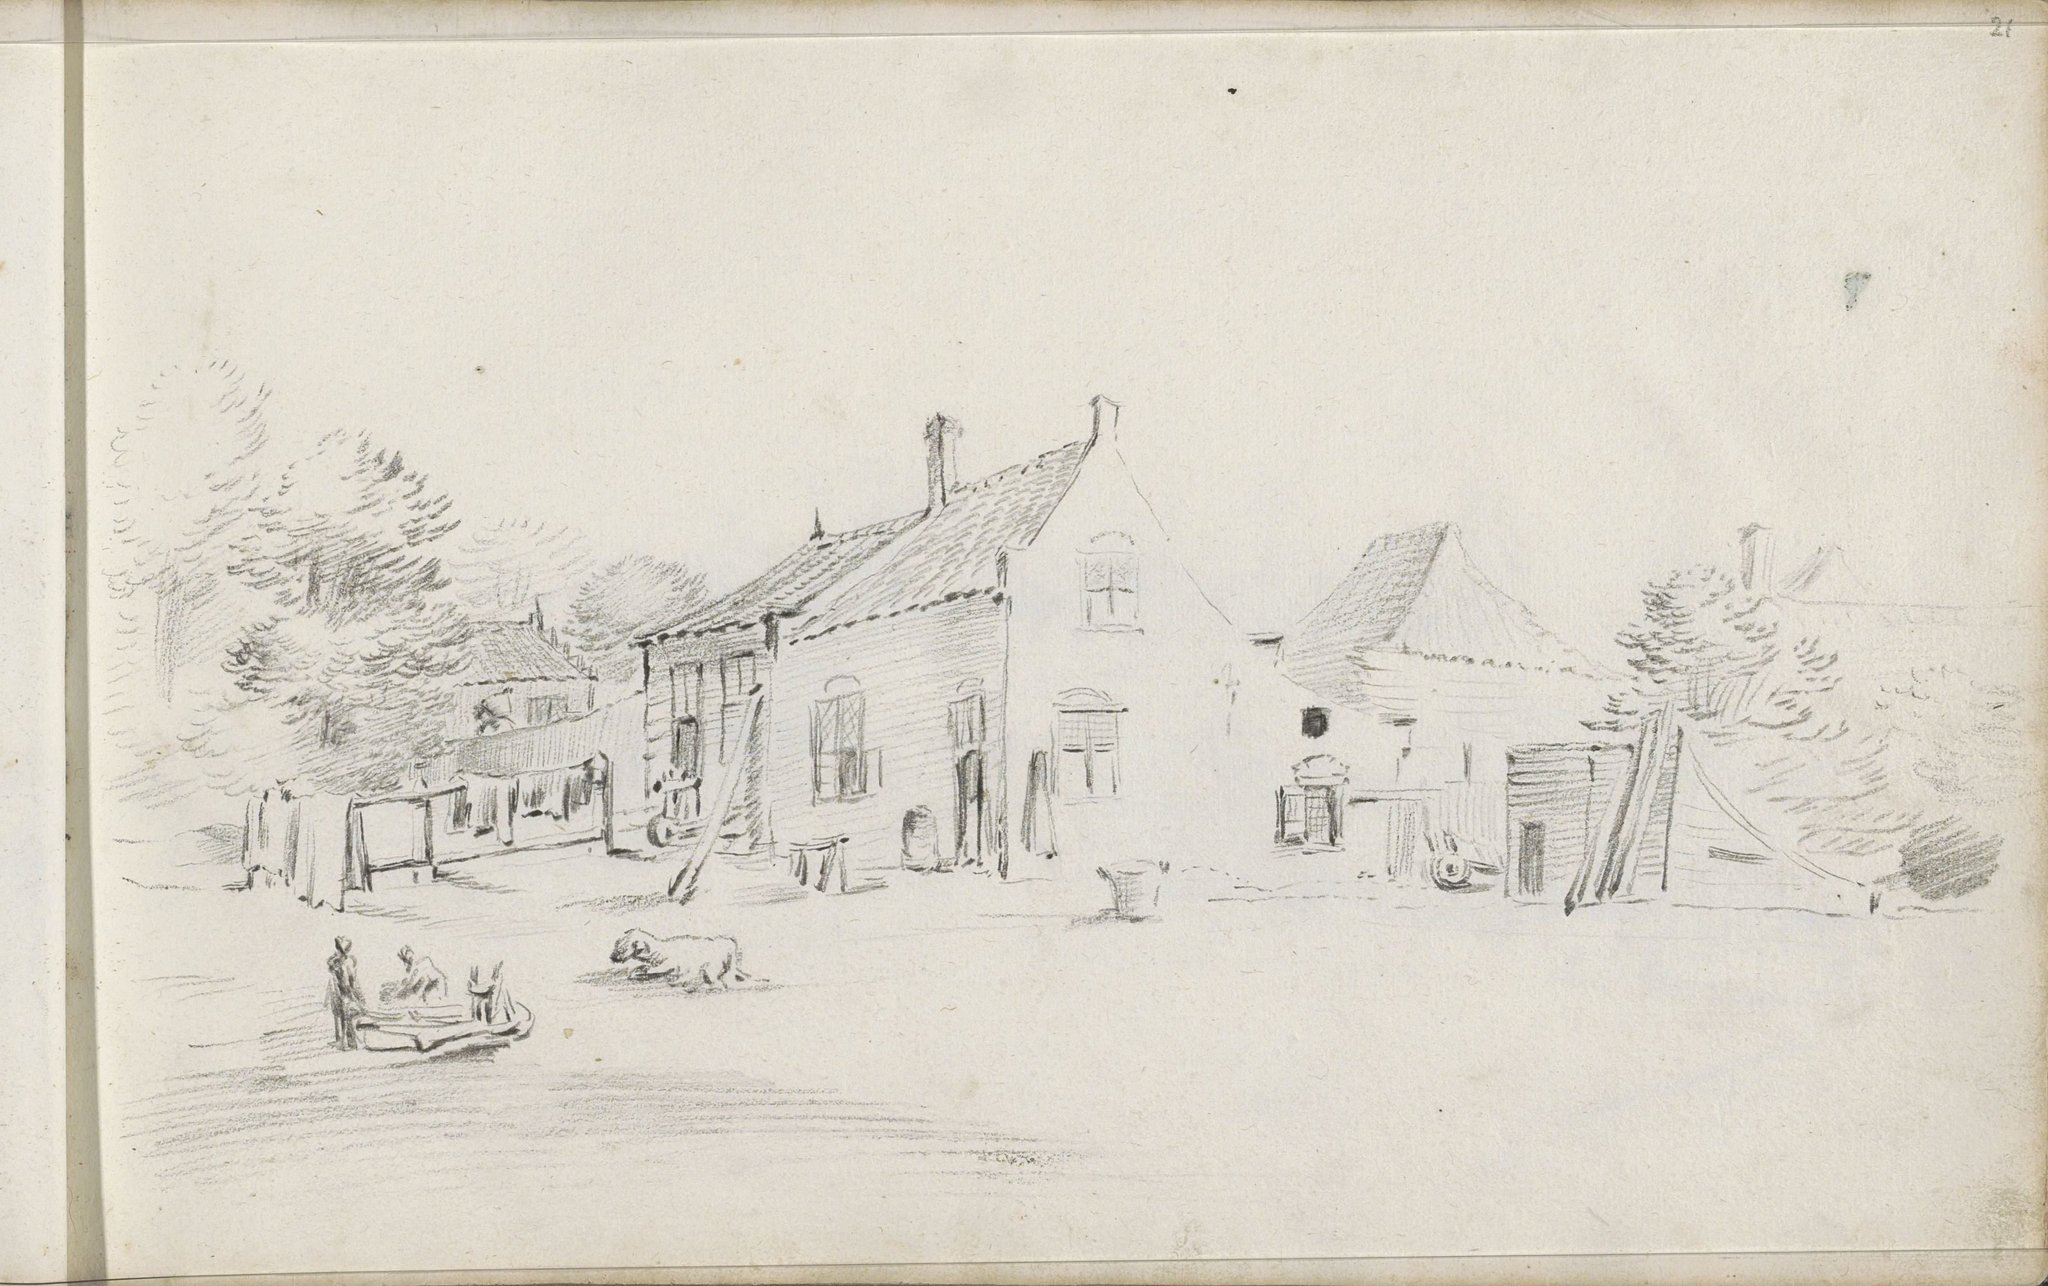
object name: sketchbook leaf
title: Boerenerf met wasgoed, een dier en figuren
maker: pieter moninckx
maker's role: draughtsman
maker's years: 1606-1686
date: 1645-1646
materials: chalk, paper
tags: farmers, farm or solitary house in landscape, hanging the wash to dry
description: Vergelijk blad 27 in dit schetsboek waarop dezelfde boerderij is weergegeven vanuit een ander perspectief.